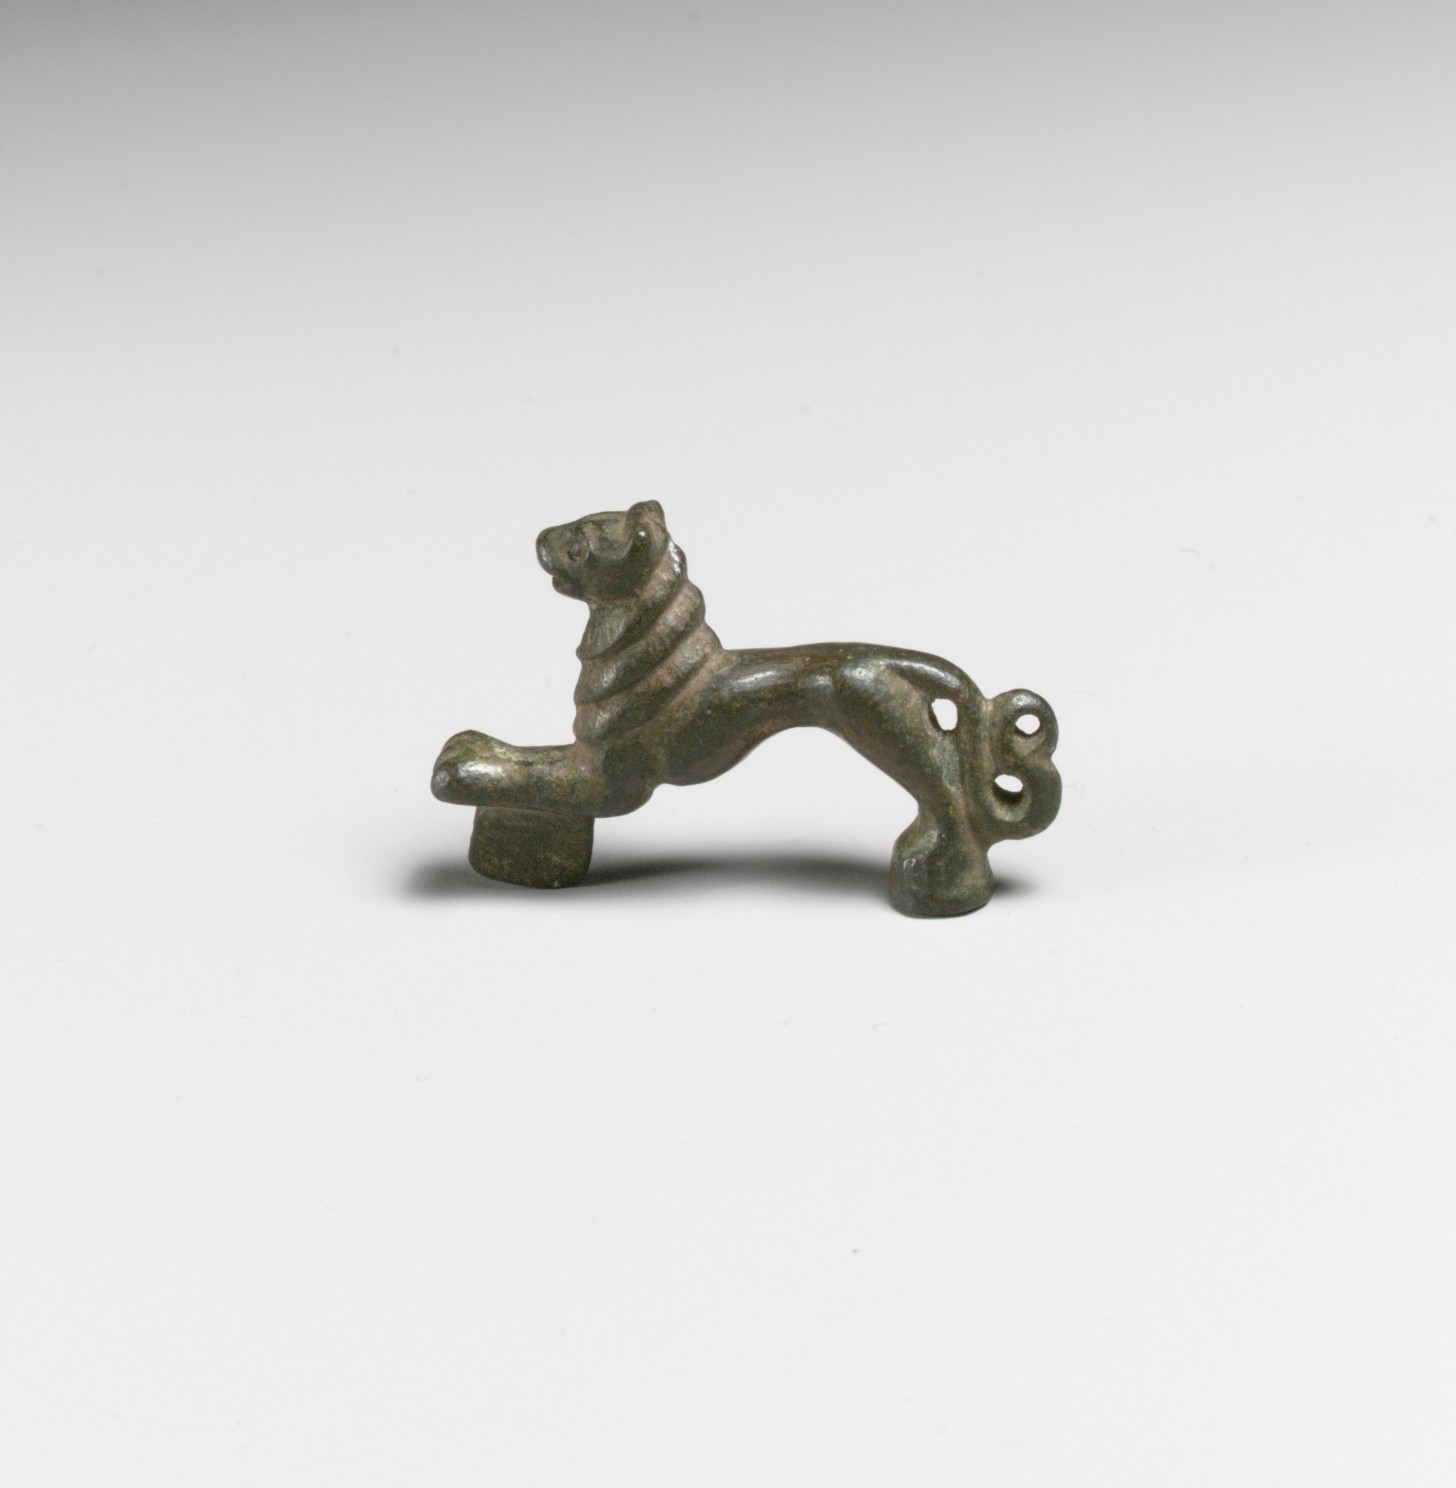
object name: handle in the form of a lion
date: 7000 BCE-330 CE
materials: bronze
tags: lions